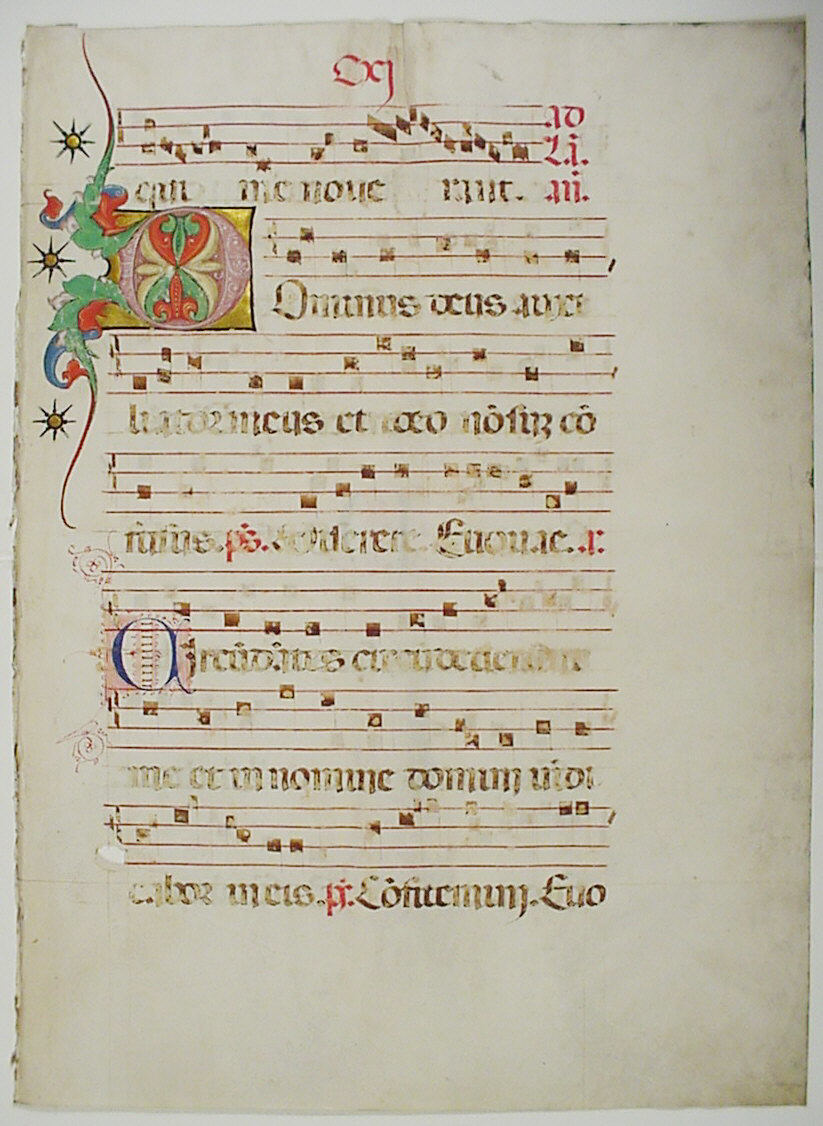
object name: antiphonary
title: Manuscript Leaf with Initial D, from an Antiphonary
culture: italian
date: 1401-1500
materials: ink, metal leaf, parchment, paint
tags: music